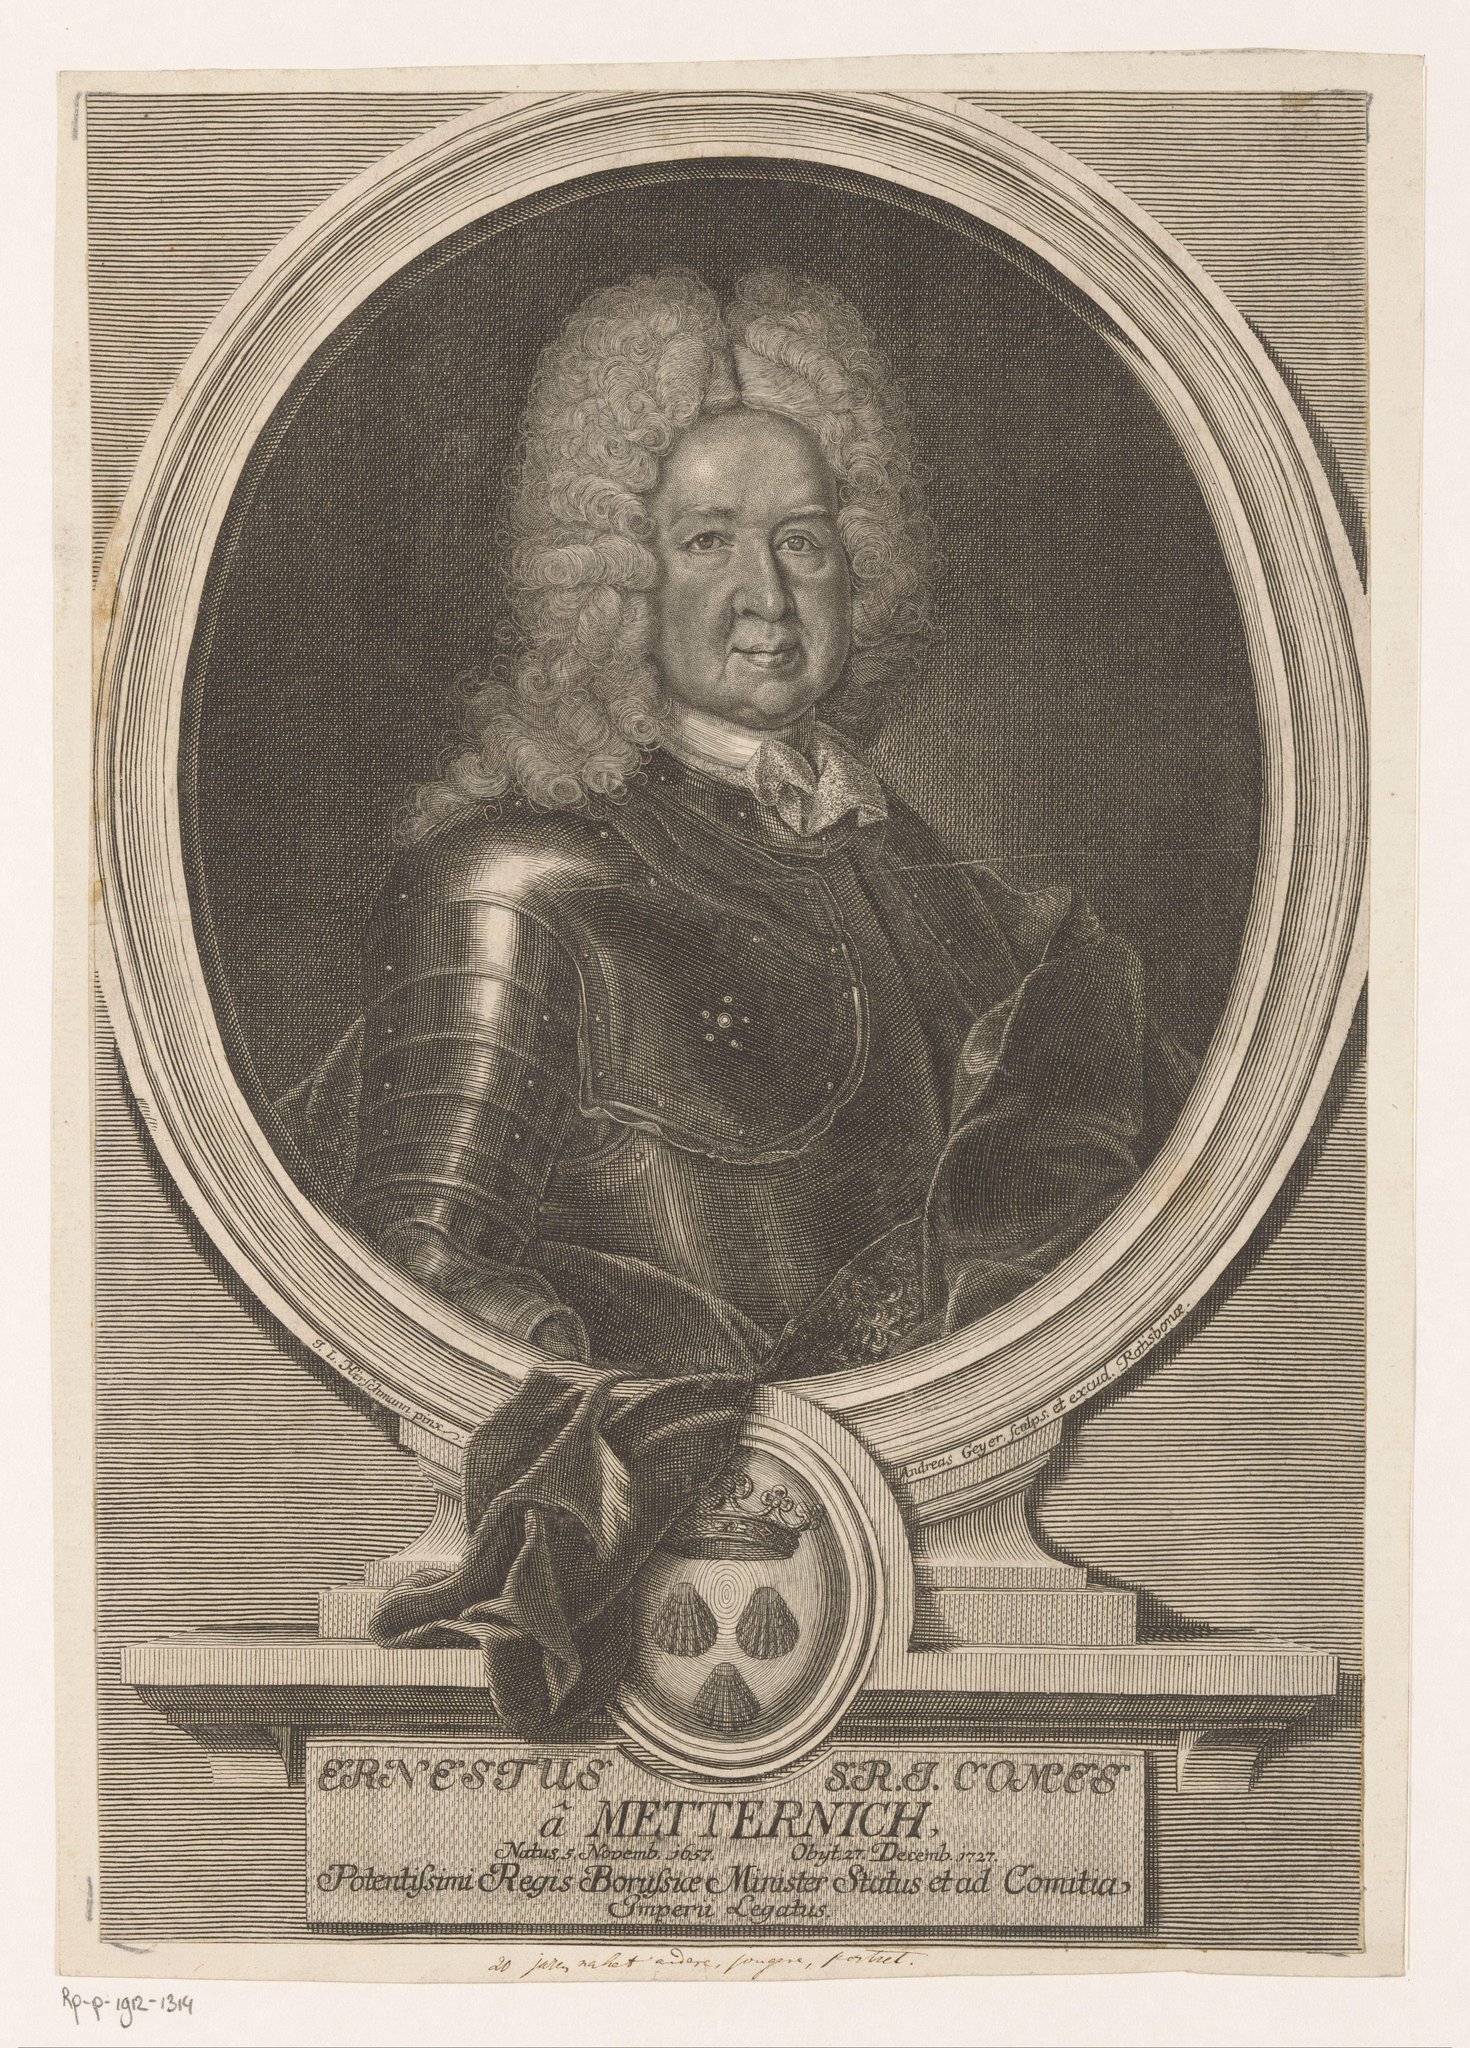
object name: print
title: Portret van Ernst Graf von Metternich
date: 1727-1729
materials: paper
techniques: engraving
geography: regensburg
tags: ornament ~ medallion, armour, historical persons, armorial bearing, heraldry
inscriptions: collector's mark: Lugt 2228